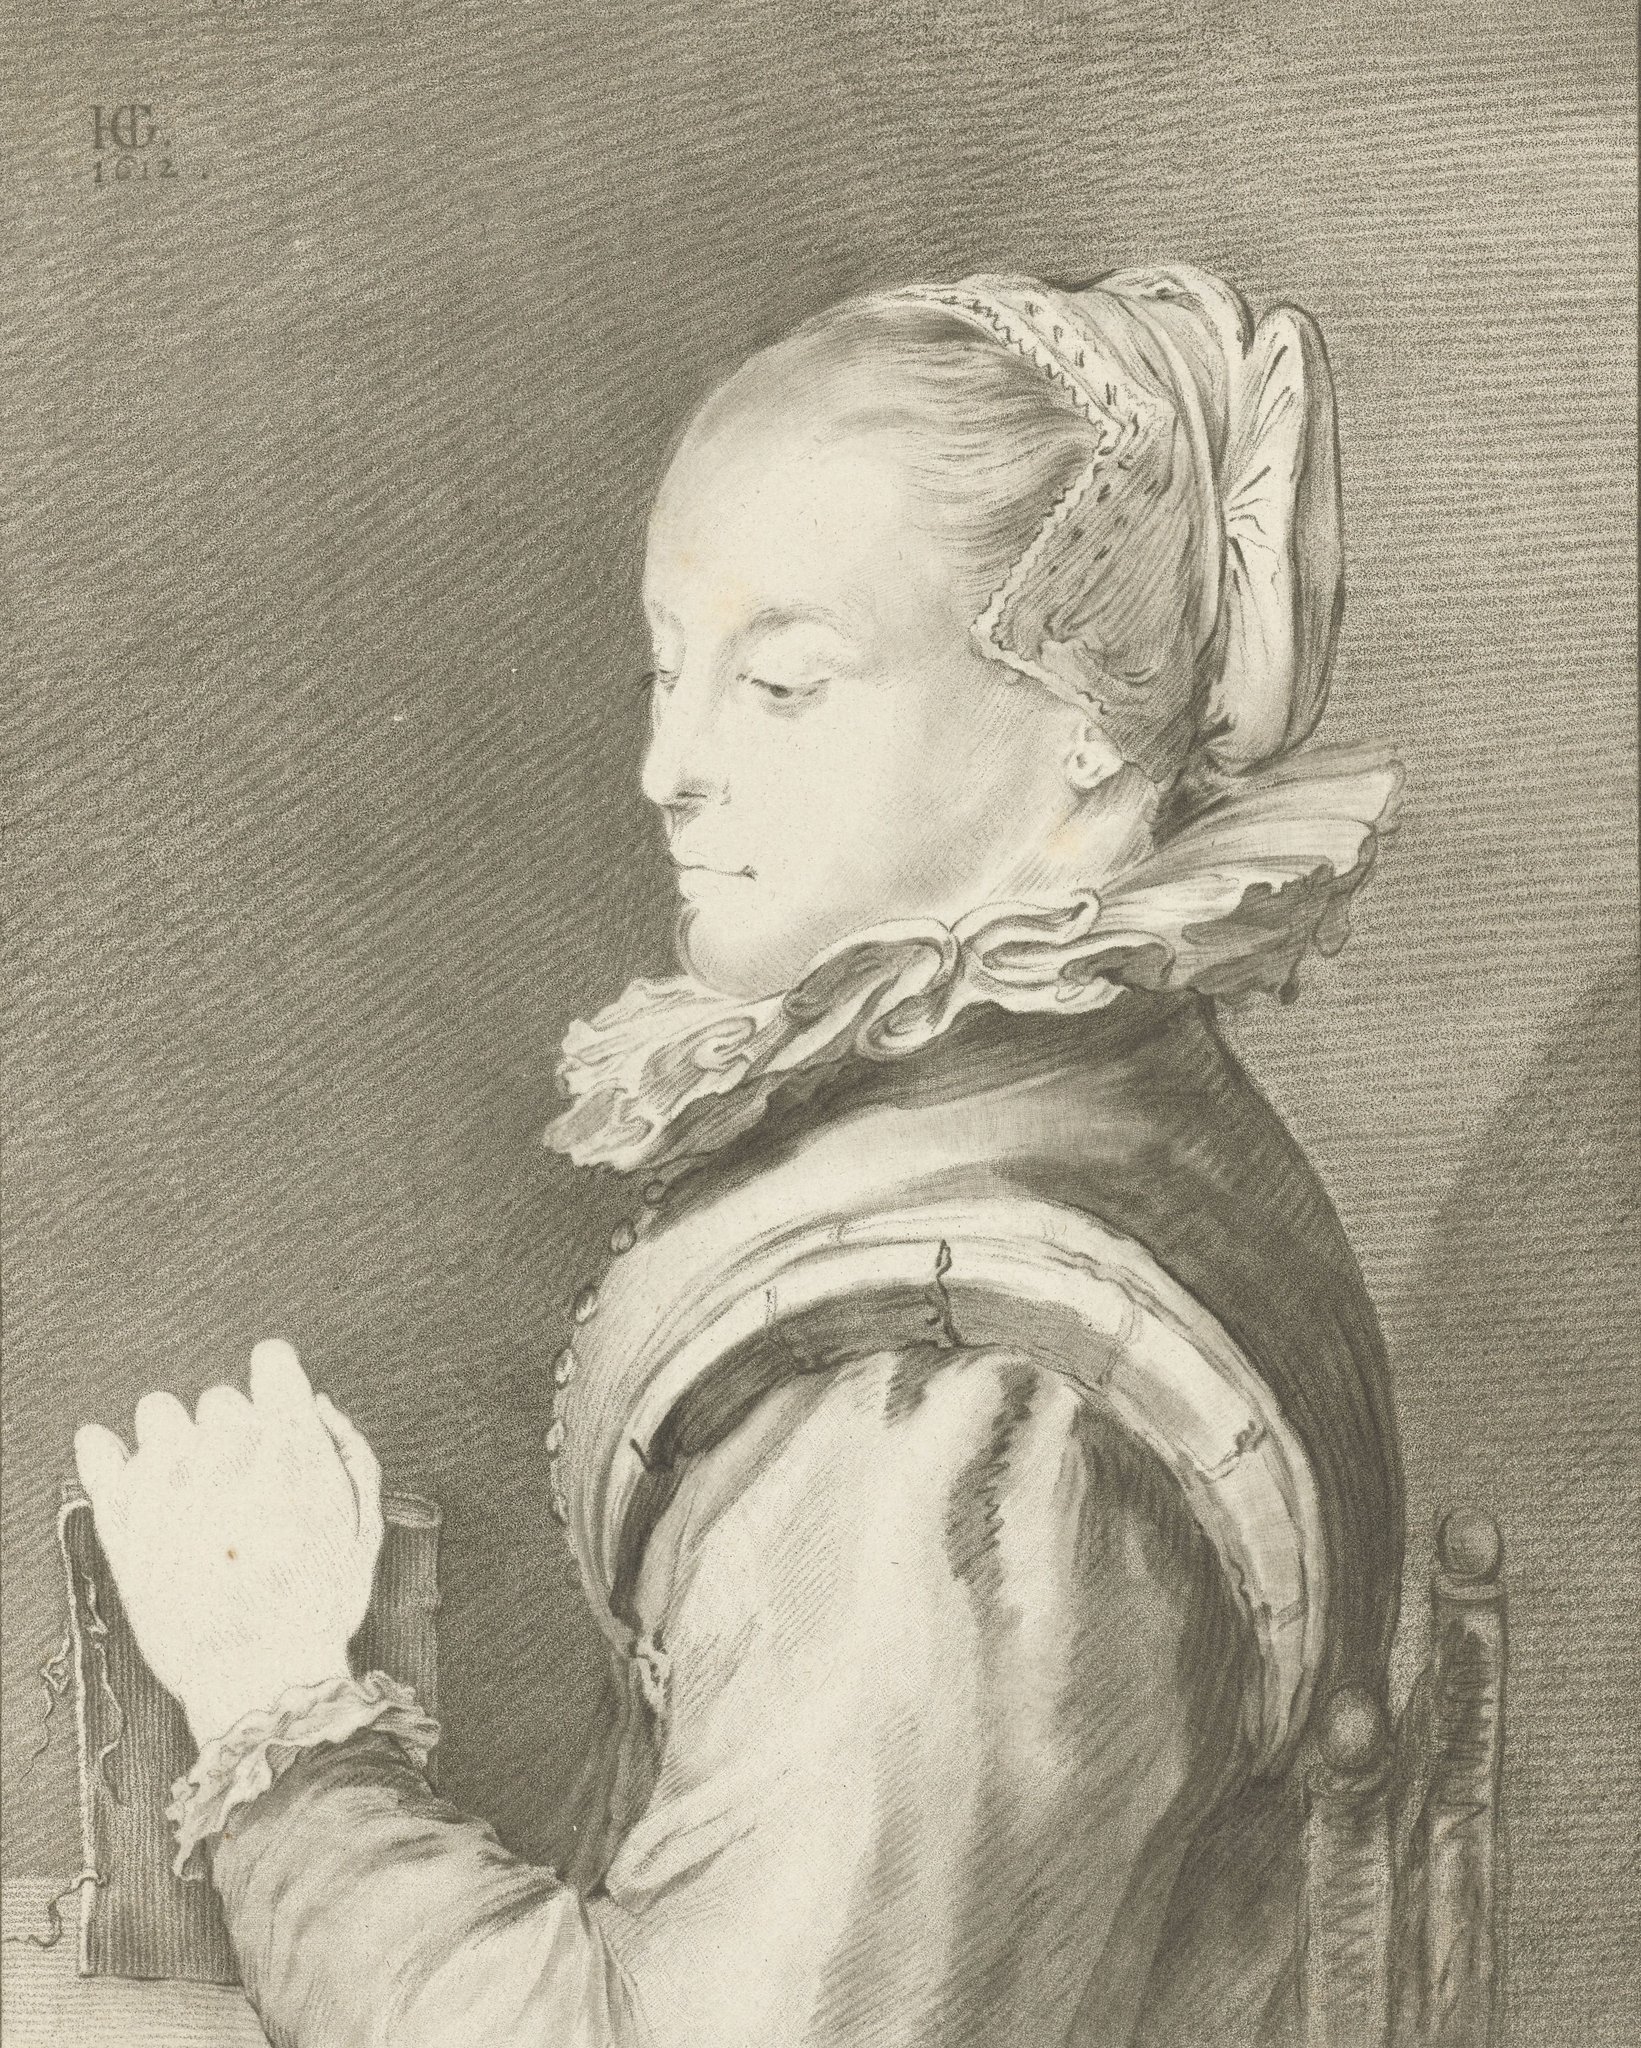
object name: print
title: Portret van Maria Tesselschade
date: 1770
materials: paper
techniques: printmaking, roulette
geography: amsterdam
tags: amsterdam, maria tesselschade roemers visscher, adult woman, book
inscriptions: collector's mark: Lugt 2228, collector's mark: Lugt 2760, inscription: ‘Geoffreerd aan mijnen waarde vriend Heer Hemsterhuis [...] P v Amstel 3 proef, af / Hendr. Goltzius del 1612 Ploos v Amstel fecit’, collector's mark: Lugt 2725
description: Naar een tekening van Hendrick Goltzius in het Amsterdam Museum. Vanaf de achttiende eeuw werd de geportretteerde, onder andere door Cornelis Ploos van Amstel, regelmatig aangeduid als zijnde Maria Tesselschade Roemer Visscher, maar dat is onjuist gebleken.